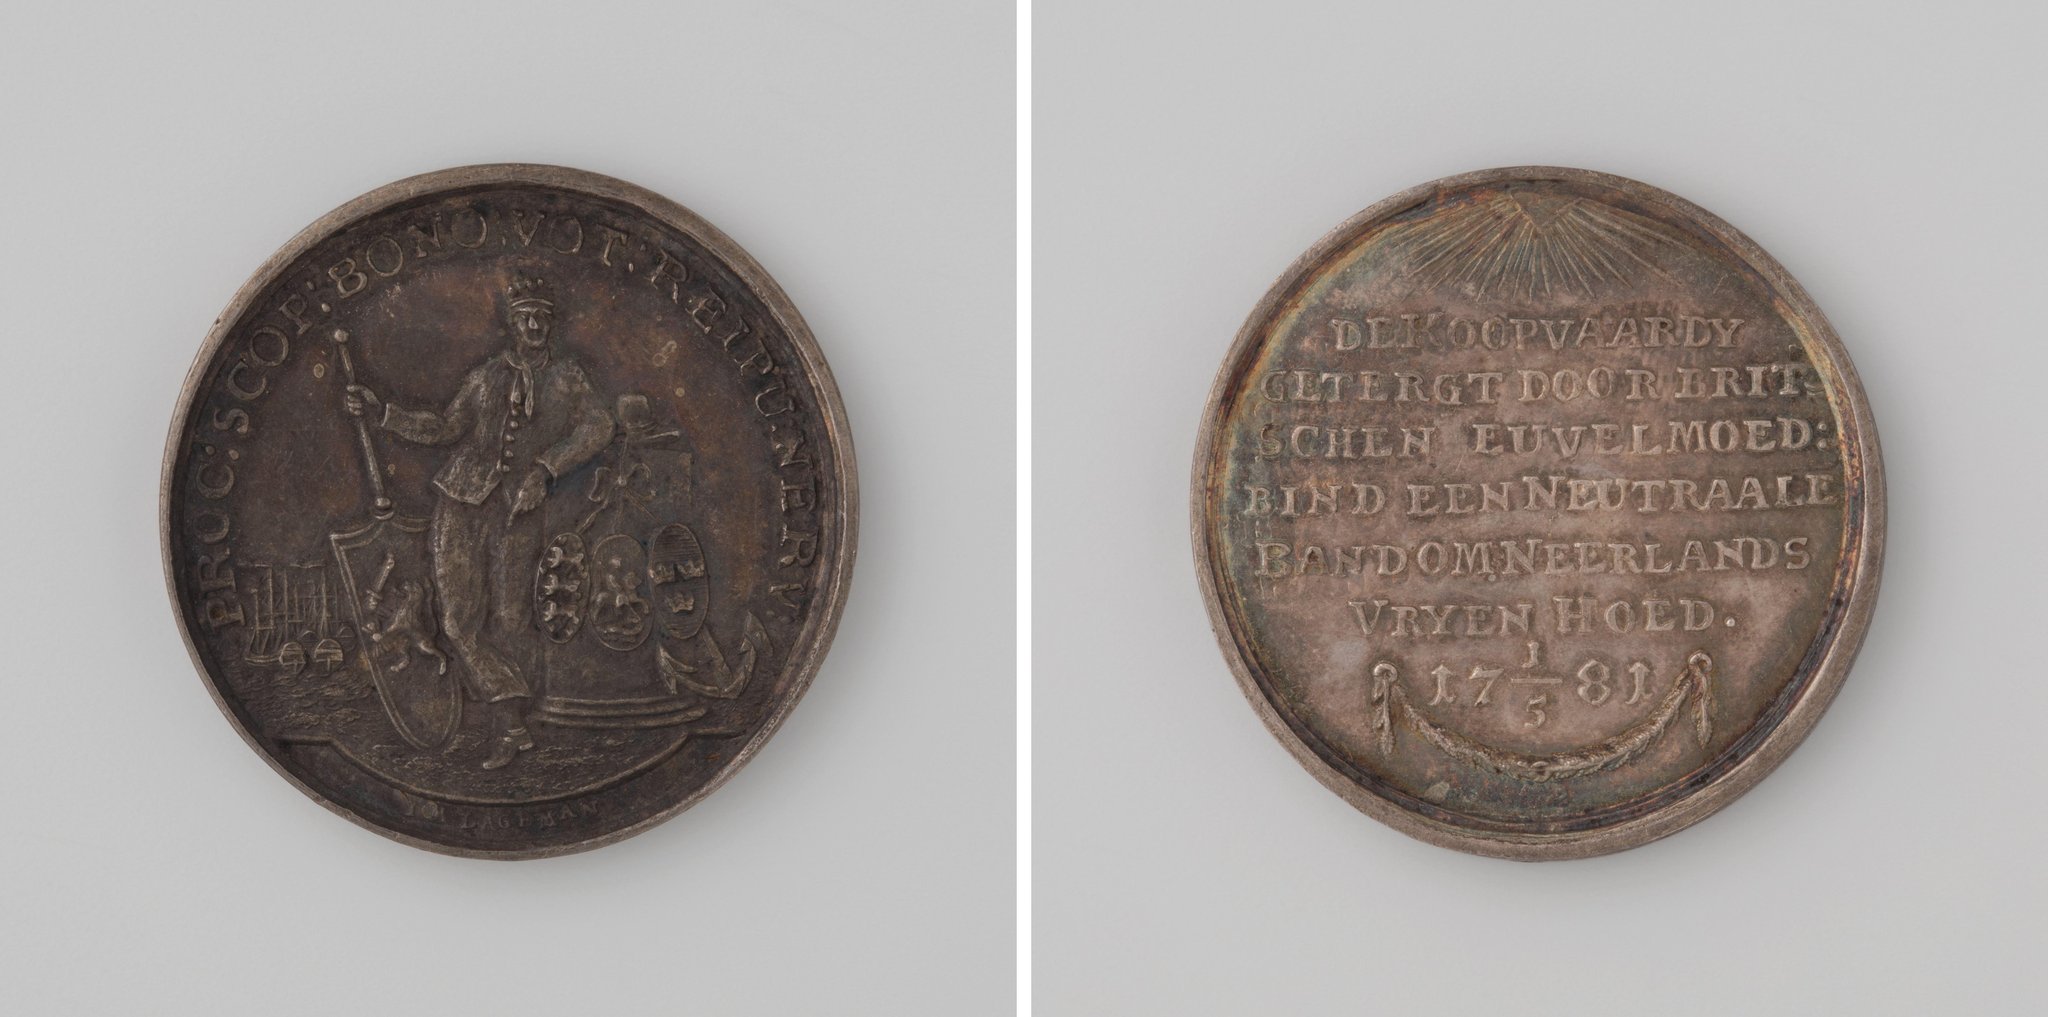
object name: history medal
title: Verbond van Gewapende Neutraliteit en vierde Engelse zeeoorlog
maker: johannes michiel lageman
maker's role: silversmith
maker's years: 1735-1809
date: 1781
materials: silver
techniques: striking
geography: amsterdam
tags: fourth anglo-dutch war